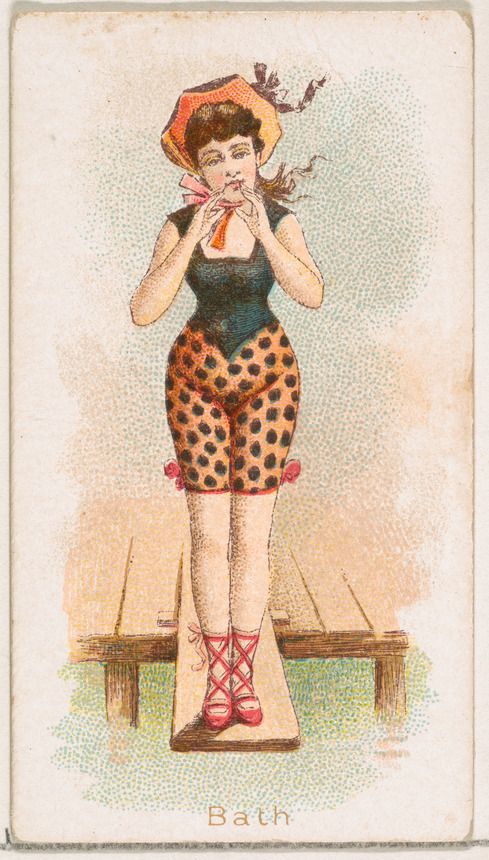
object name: print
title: Bath, from the Fancy Bathers series (N187) issued by Wm. S. Kimball & Co.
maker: william s. kimball & company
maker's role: publisher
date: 1889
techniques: color lithograph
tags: women